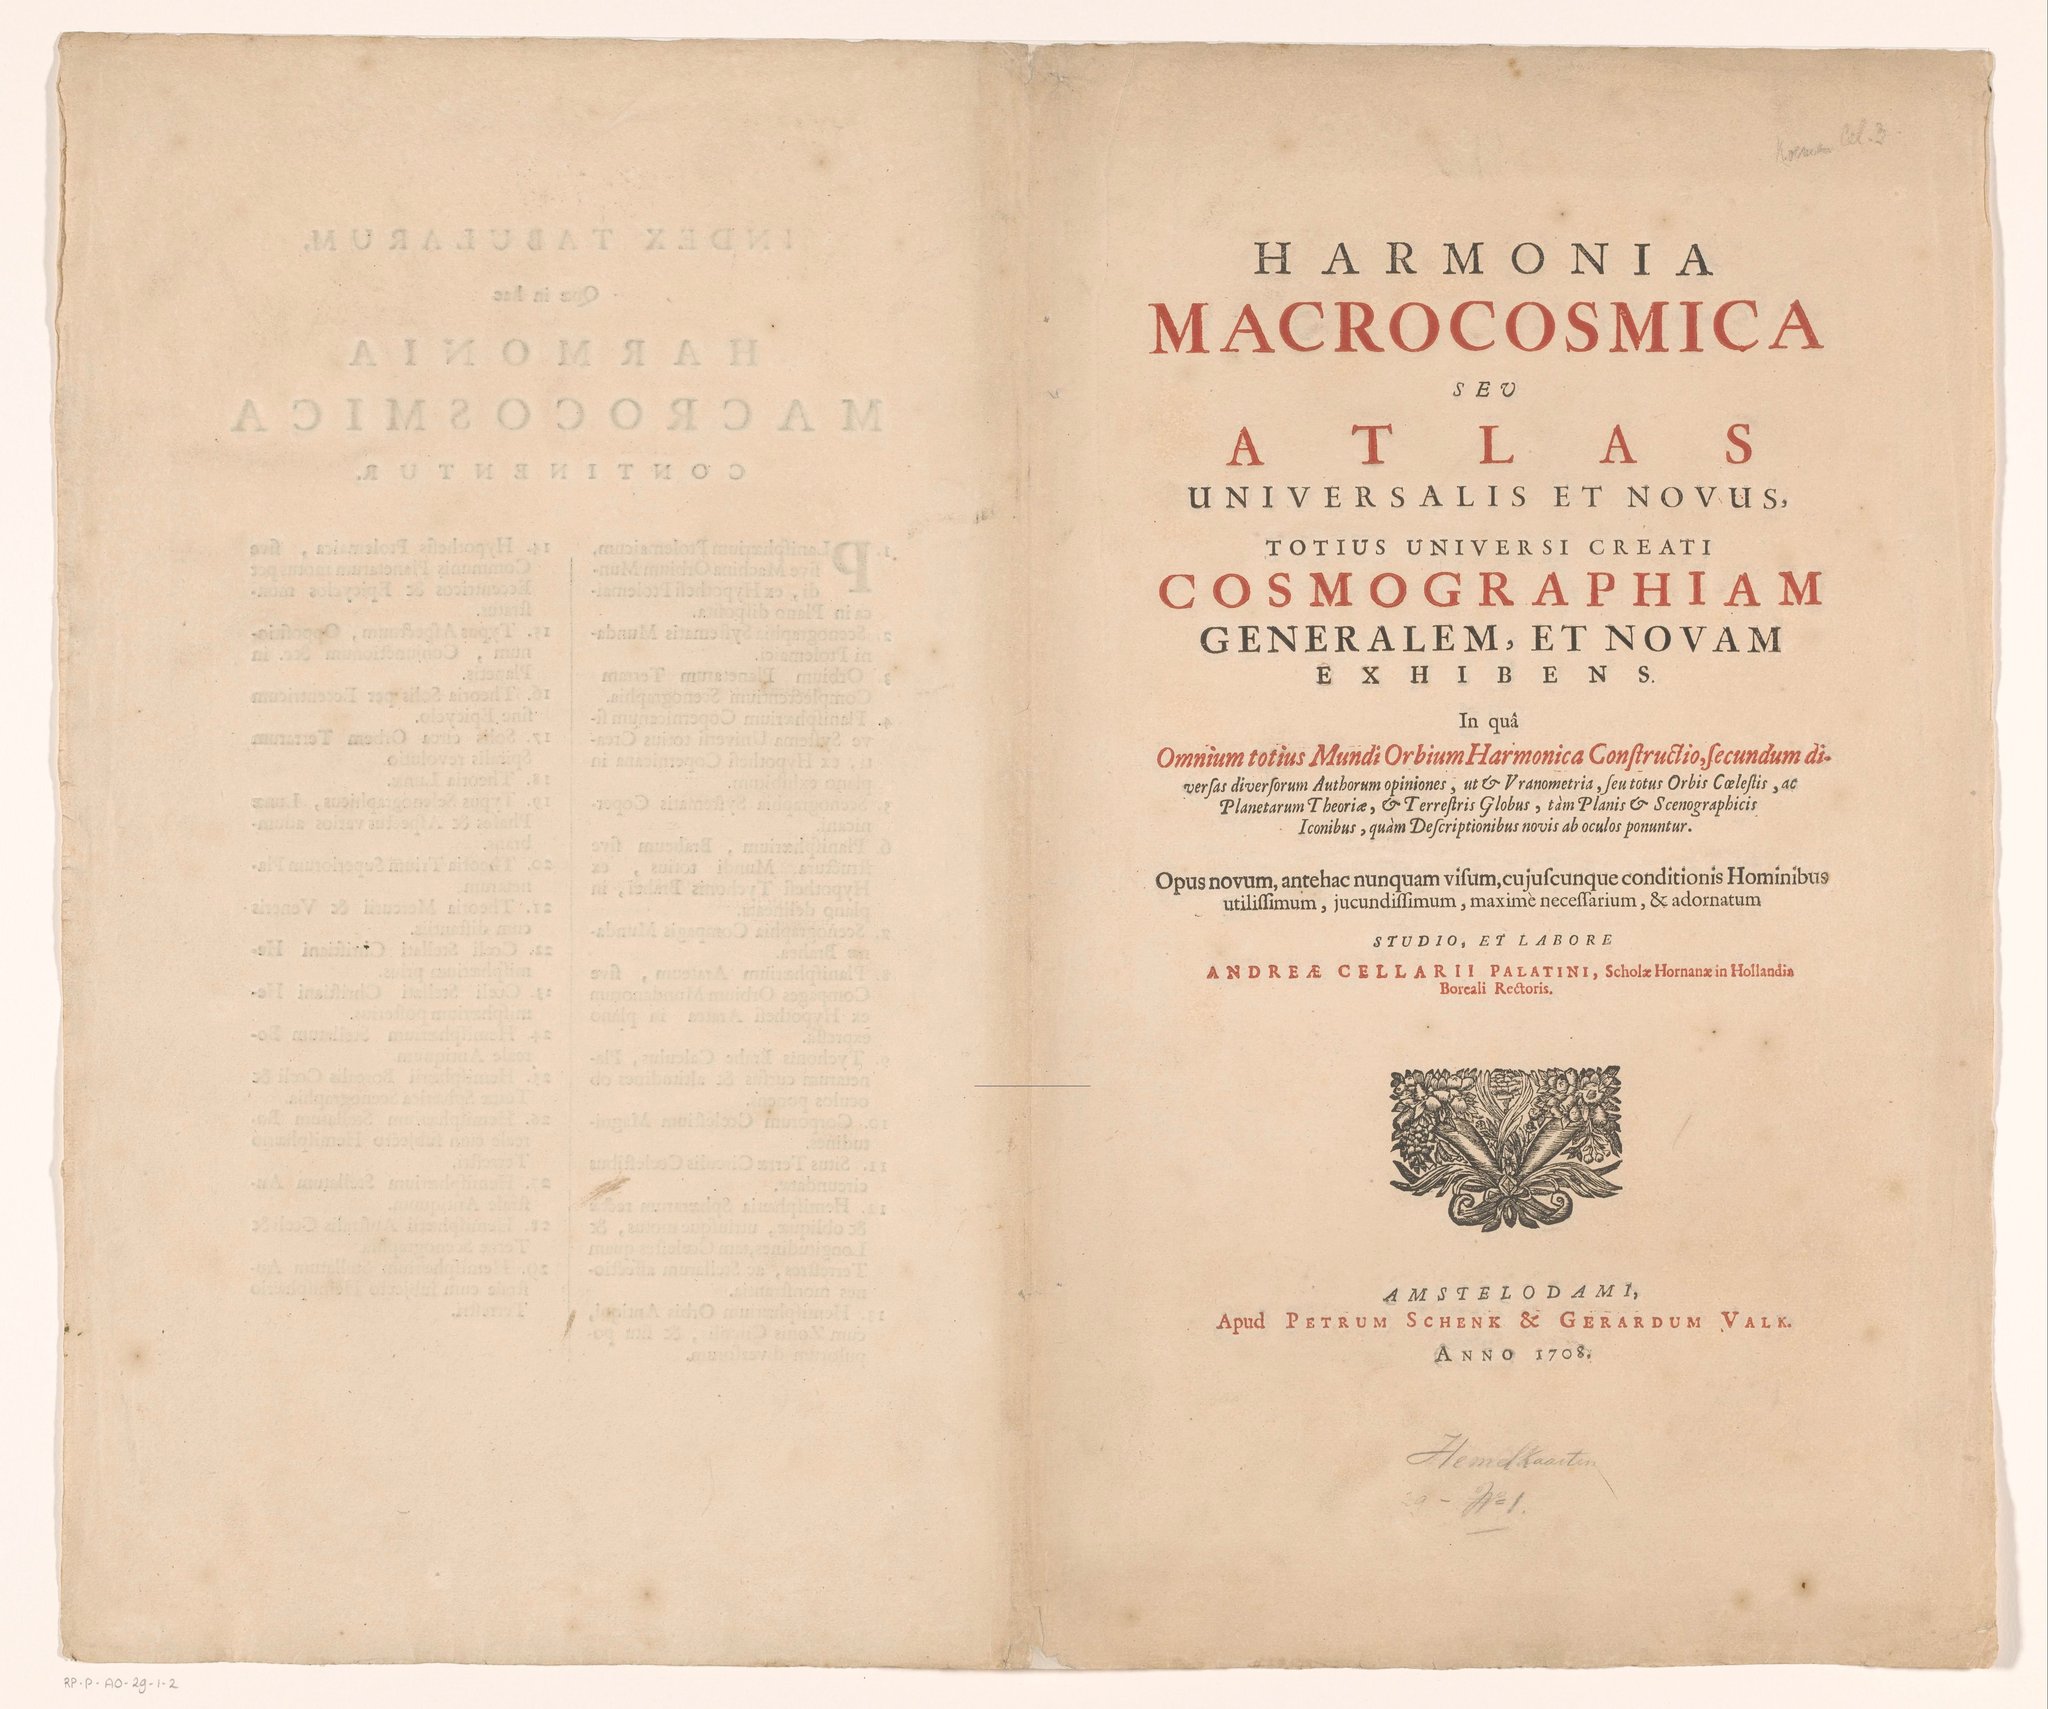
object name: titelblad, titelpagina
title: Harmonica Macrocosmica seu Atlas Universalis et Novus (...)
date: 1708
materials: paper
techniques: letterpress printing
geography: amsterdam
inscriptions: date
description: Titelpagina voor: Cellarius, Andreas. Harmonia Macrocosmica seu Atlas Universalis et Novus. Amsterdam: Pieter Schenk (I) en Gerard Valck, 1708. Zie ook: Gent, Rob van. De hemelatlas van Andreas Cellarius: het meesterwerk van een vergeten Hollandse kosmograaf. In: Caert-Thresoor, jaargang 19, nr. 1, 2000.